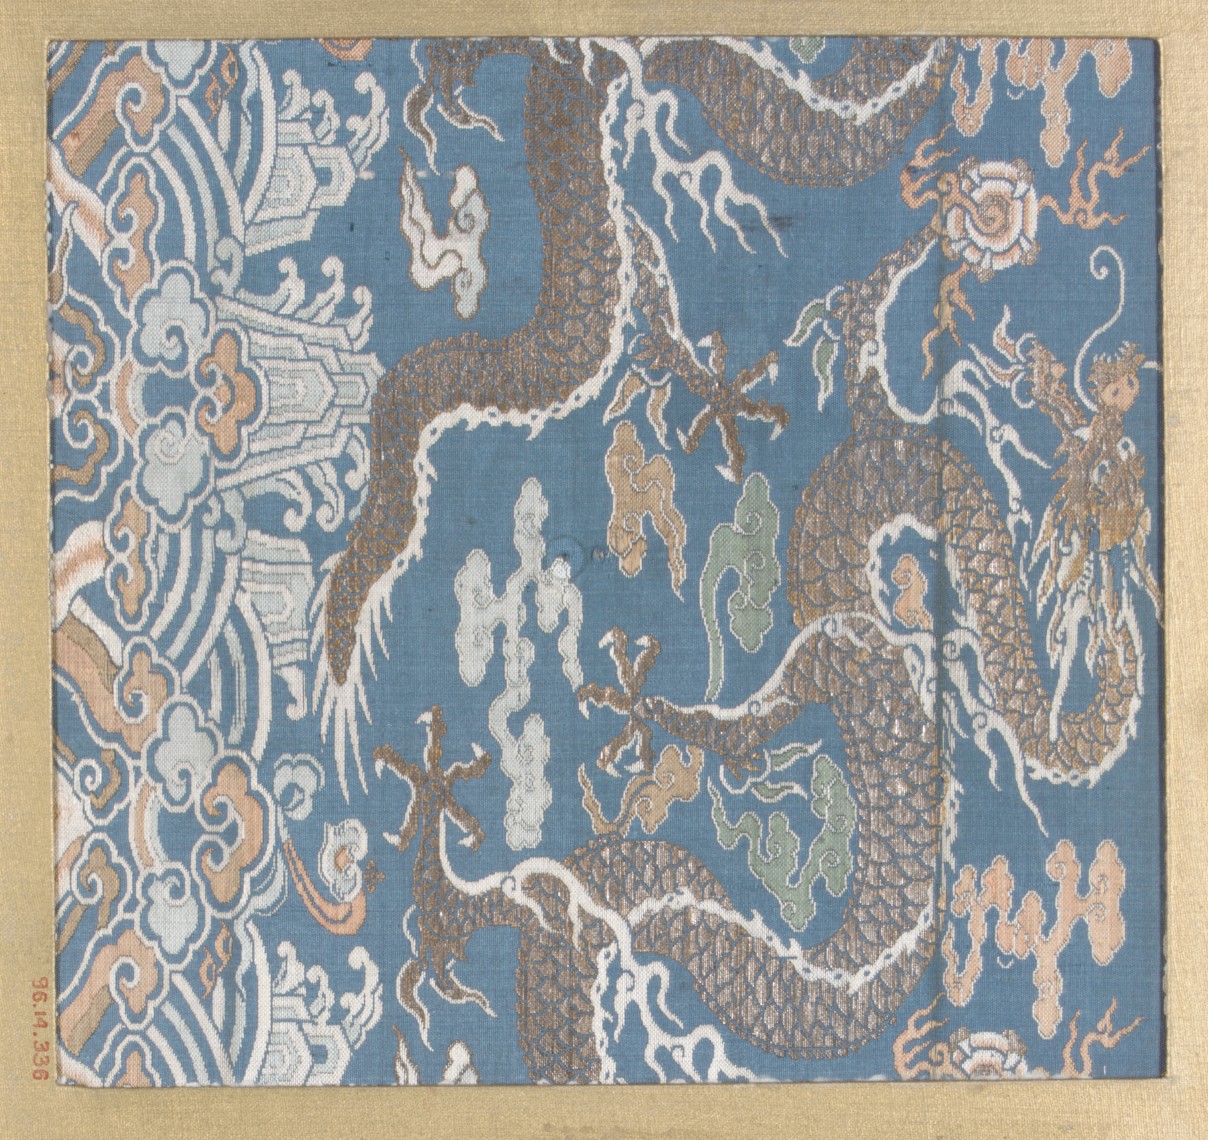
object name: piece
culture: chinese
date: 1368-1644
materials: silk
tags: dragons